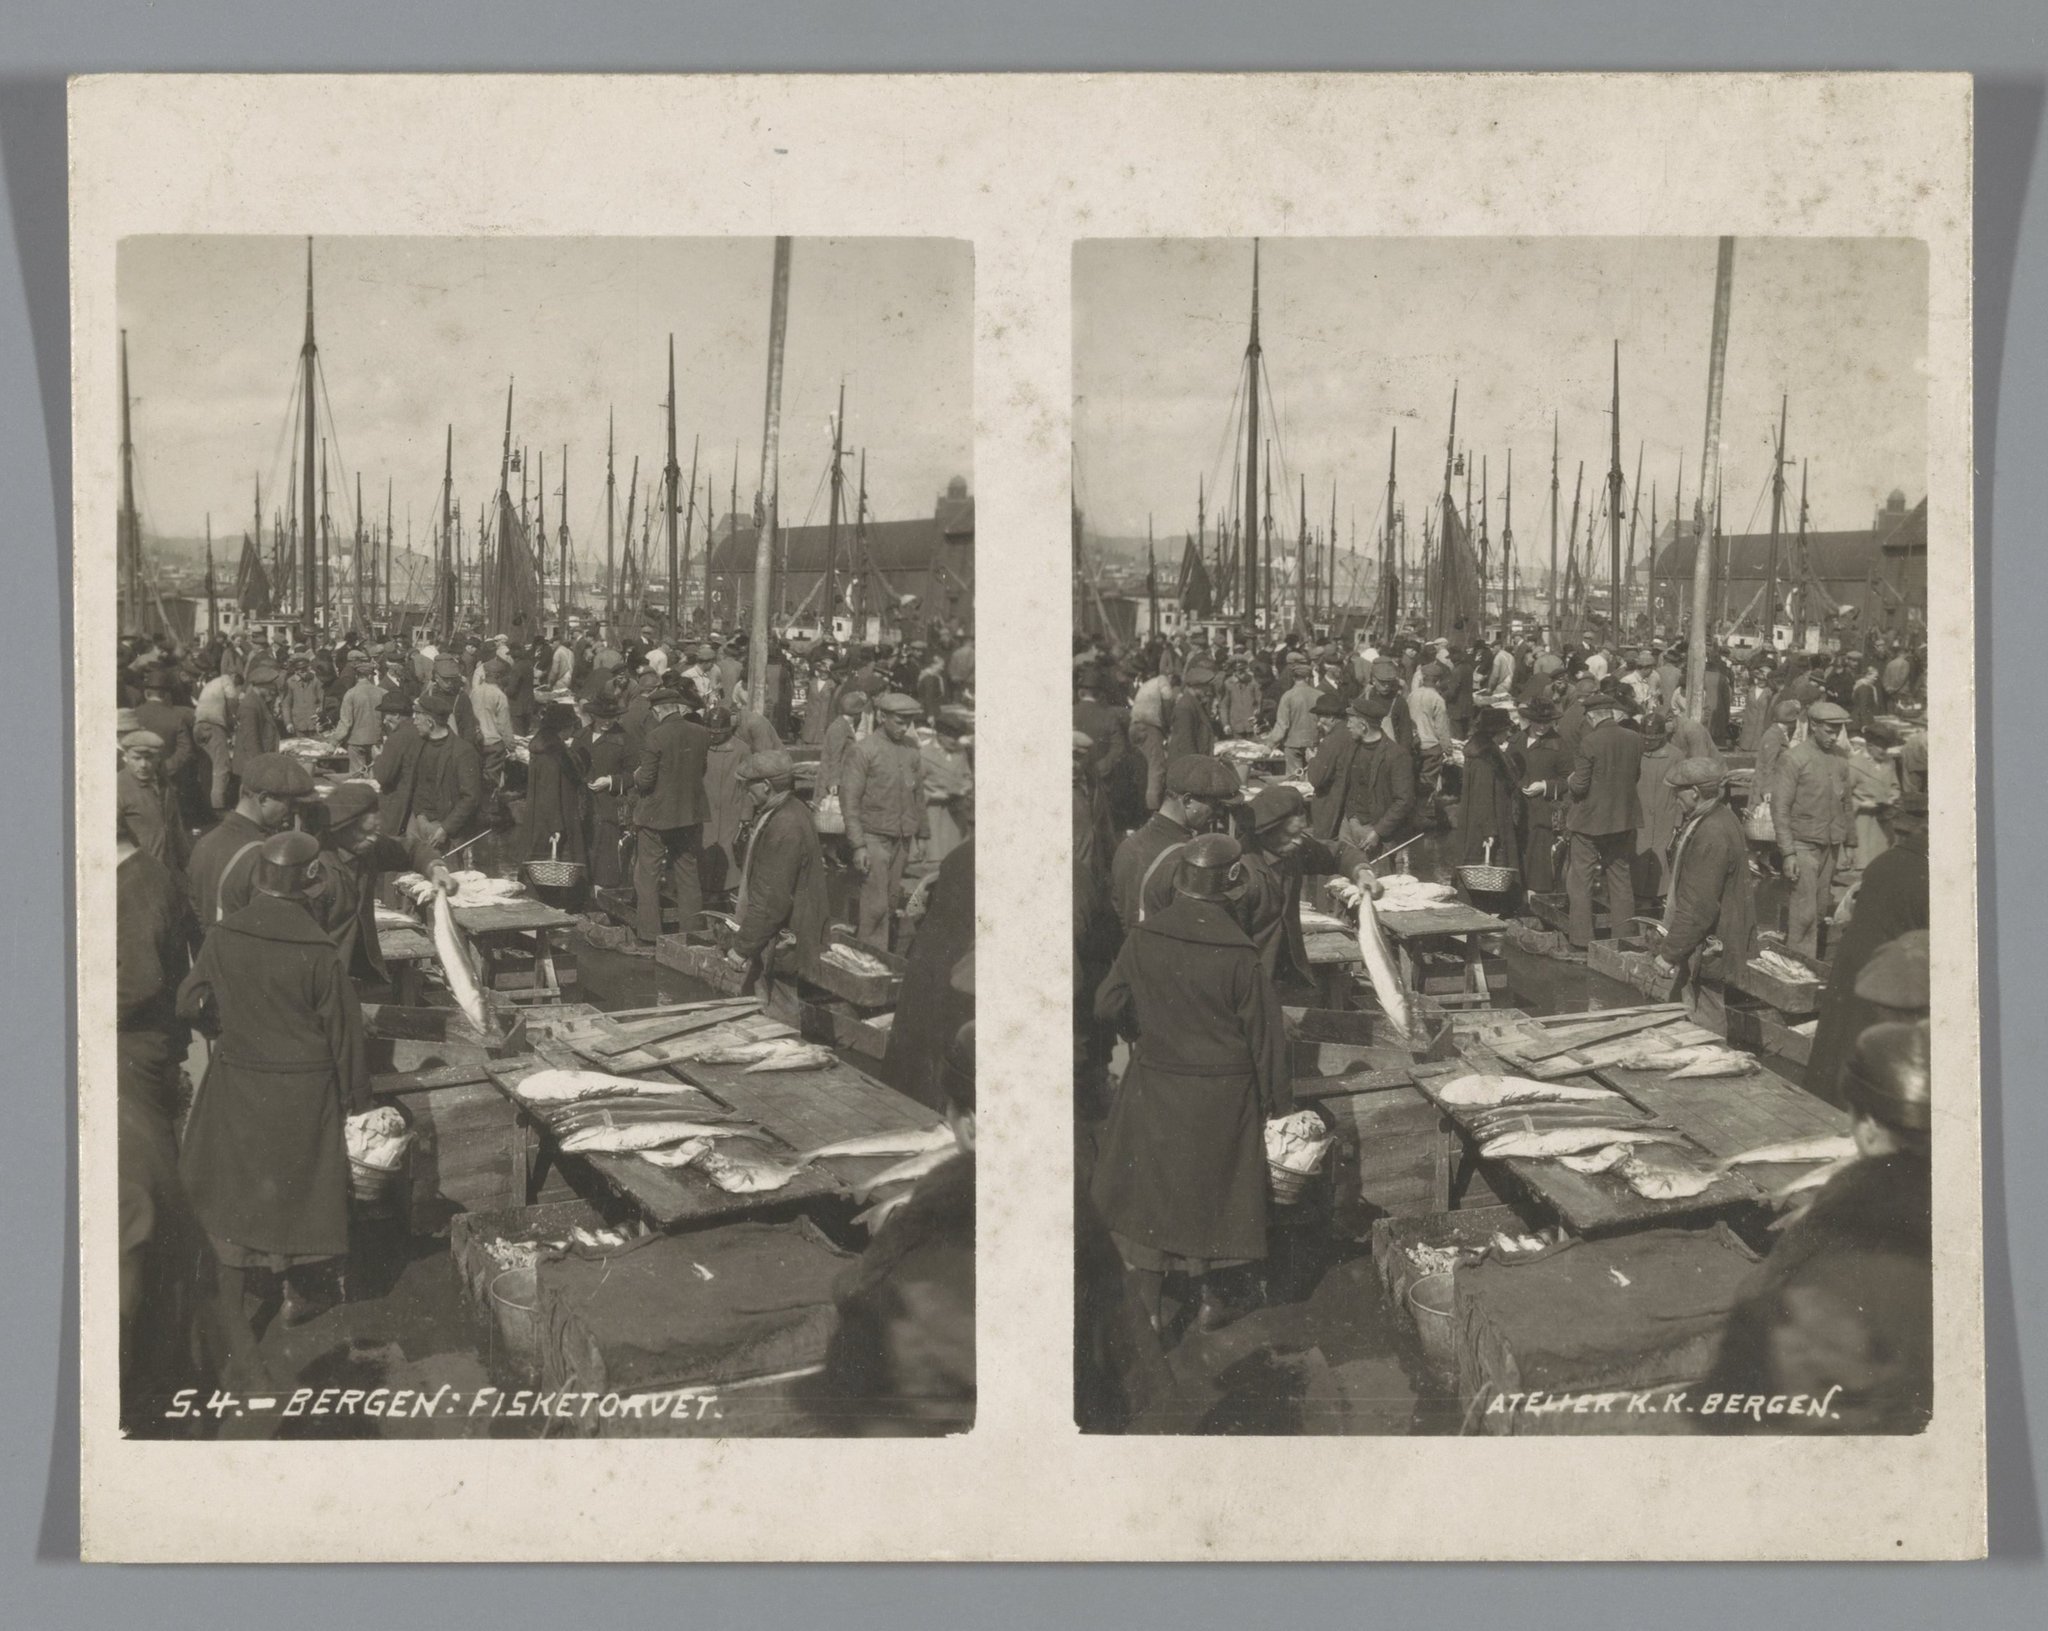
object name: stereograph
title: Vismarkt in de haven van Bergen, Noorwegen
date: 1898-1935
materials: paper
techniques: gelatin silver print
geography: bergen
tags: fishes, market, selling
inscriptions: number: ‘5.4.’